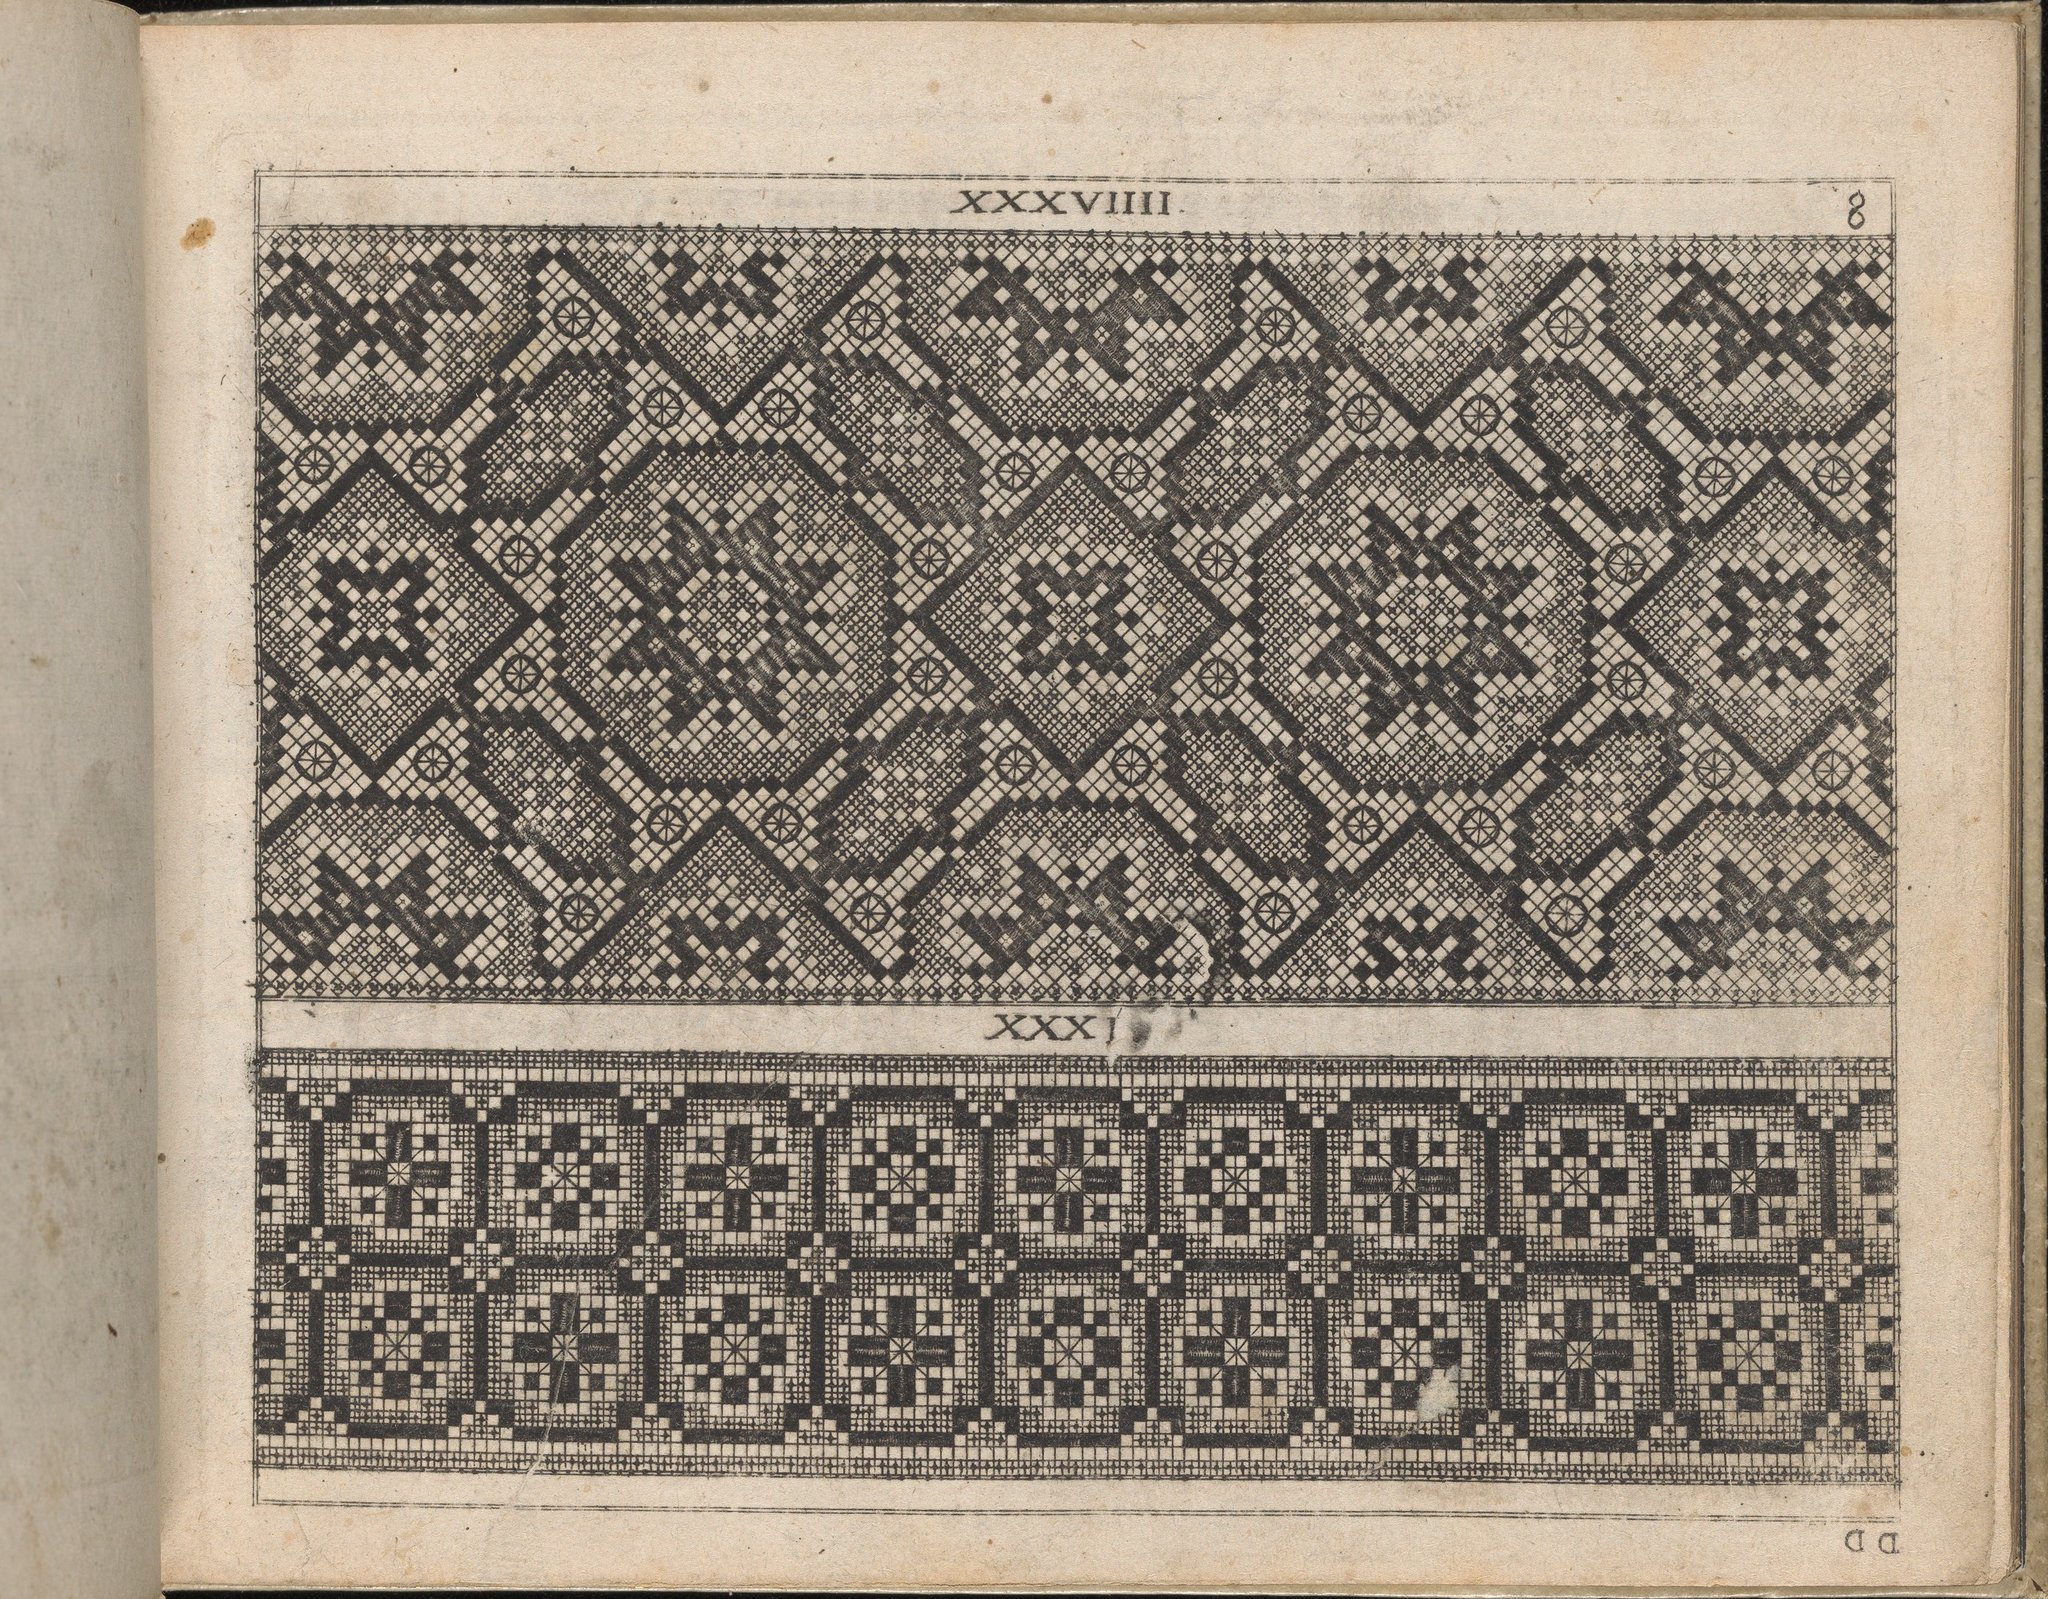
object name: book print ornament architecture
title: Newes Modelbuch in Kupffer (Page 17r)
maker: johann sibmacher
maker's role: artist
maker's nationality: german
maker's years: 1590-1611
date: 1604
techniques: etching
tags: ornament